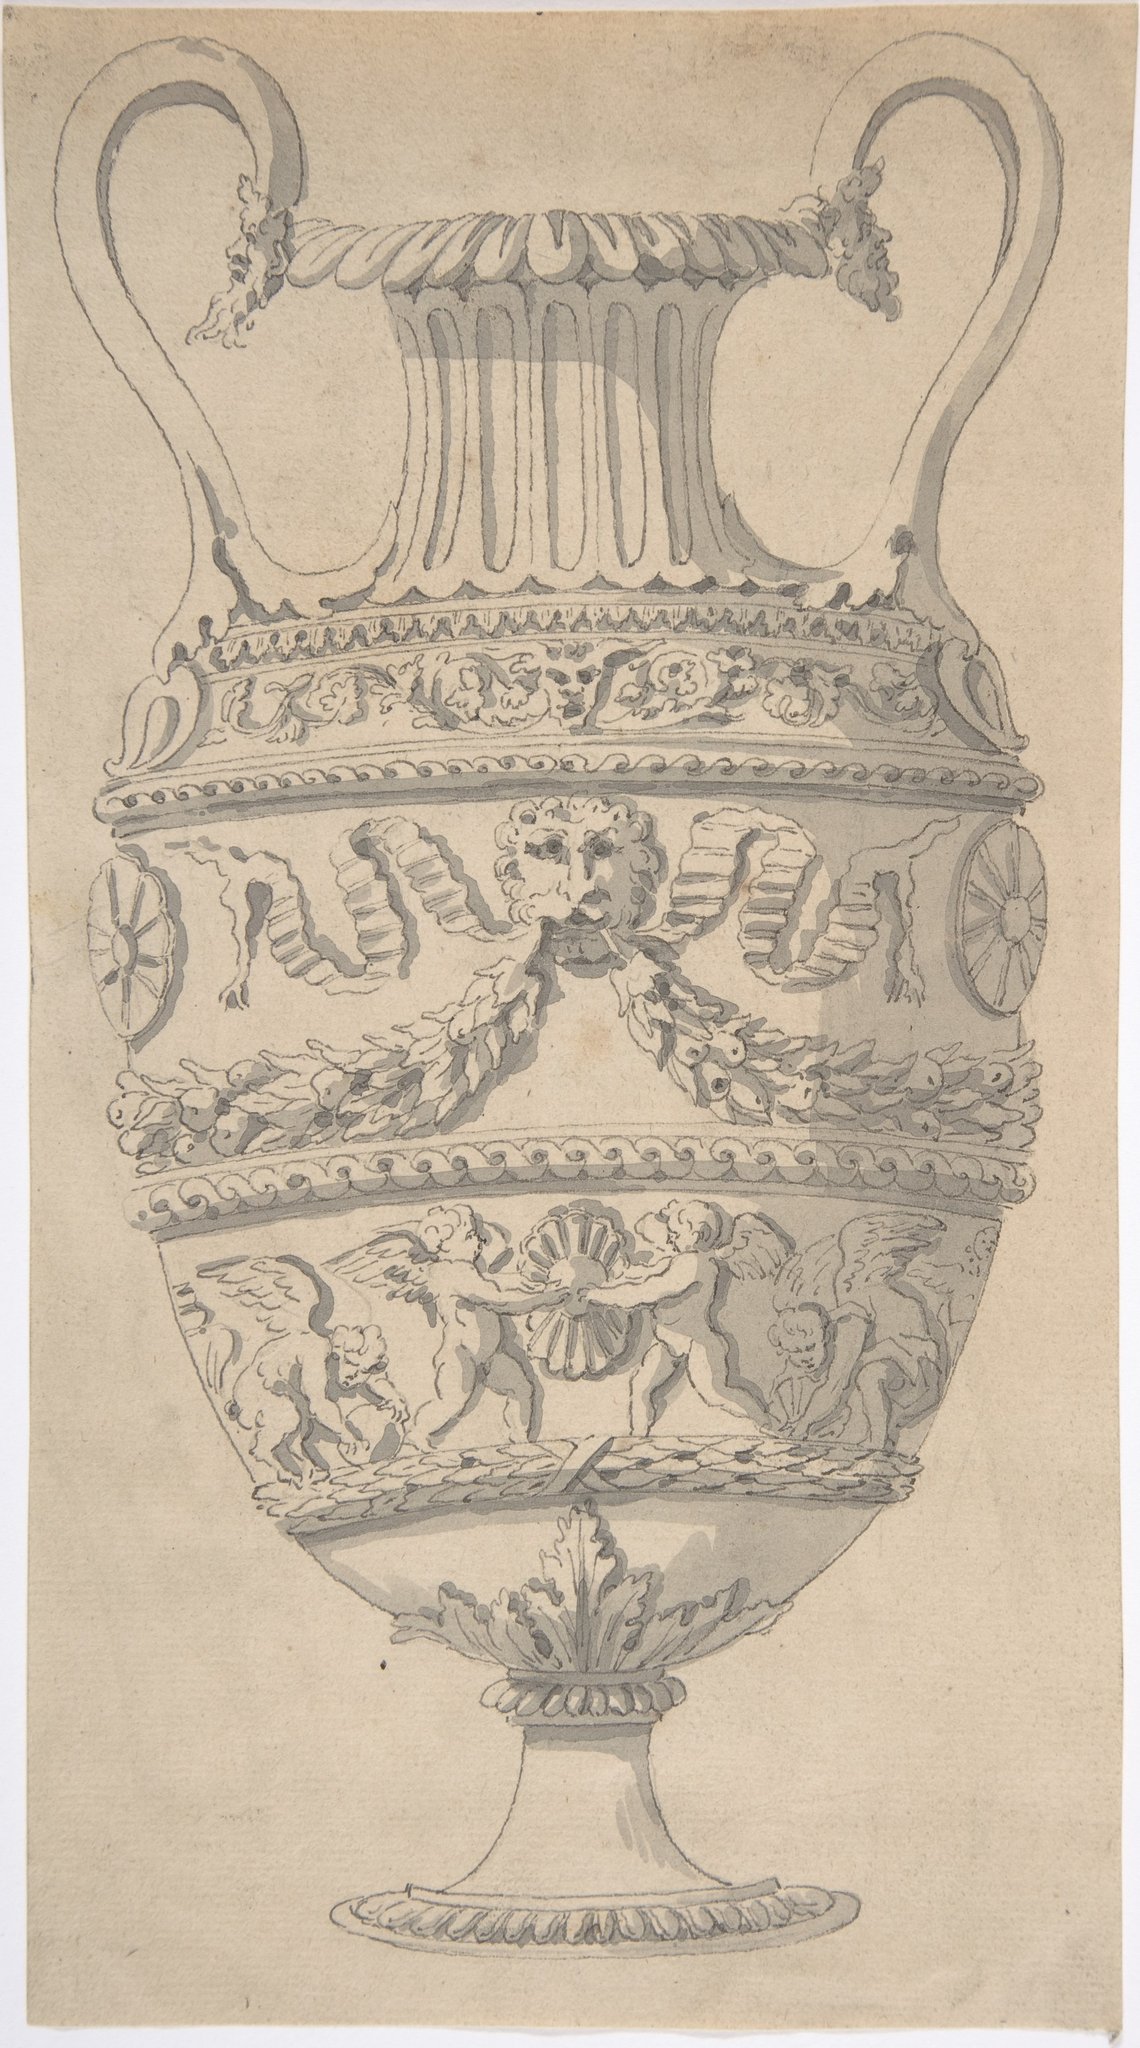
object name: drawing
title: Drawing of an Urn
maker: anonymous, french, 18th century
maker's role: artist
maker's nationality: french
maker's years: 1700-1800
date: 1701-1800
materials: graphite, ink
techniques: brush, pen, wash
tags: urns